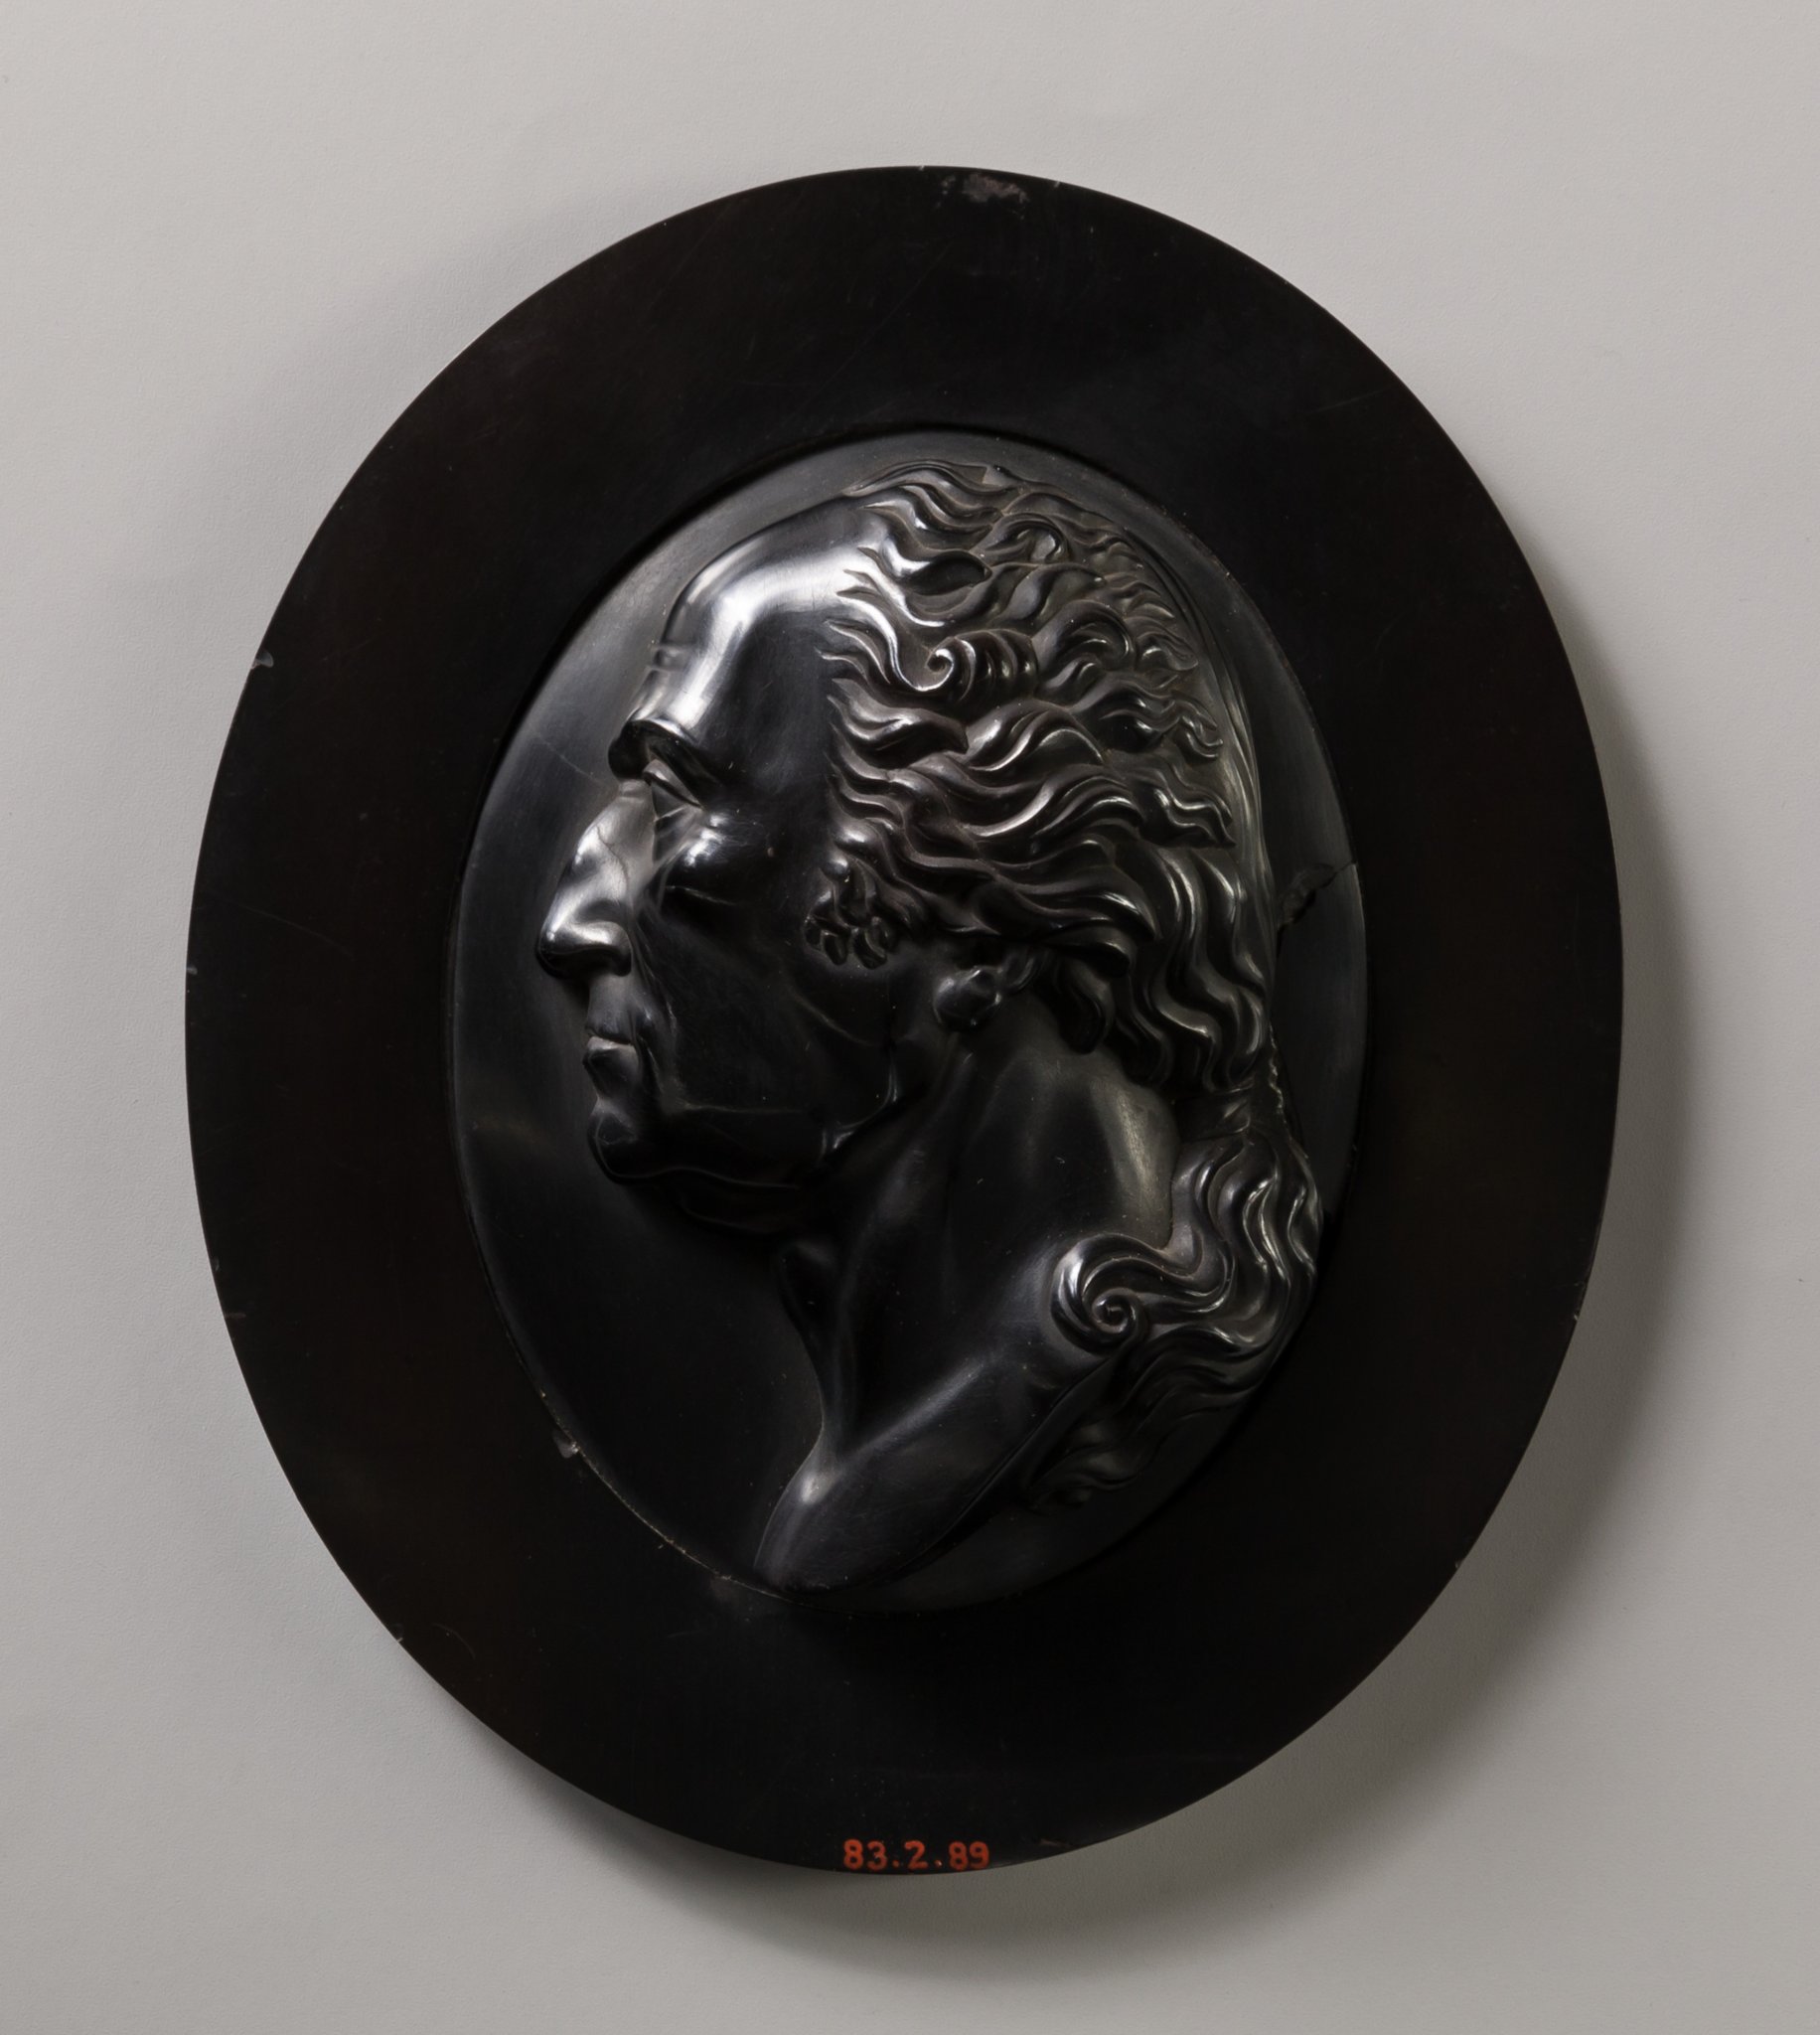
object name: medal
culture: american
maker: william spohn baker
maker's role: maker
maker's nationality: american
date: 1876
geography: united states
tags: men,profiles